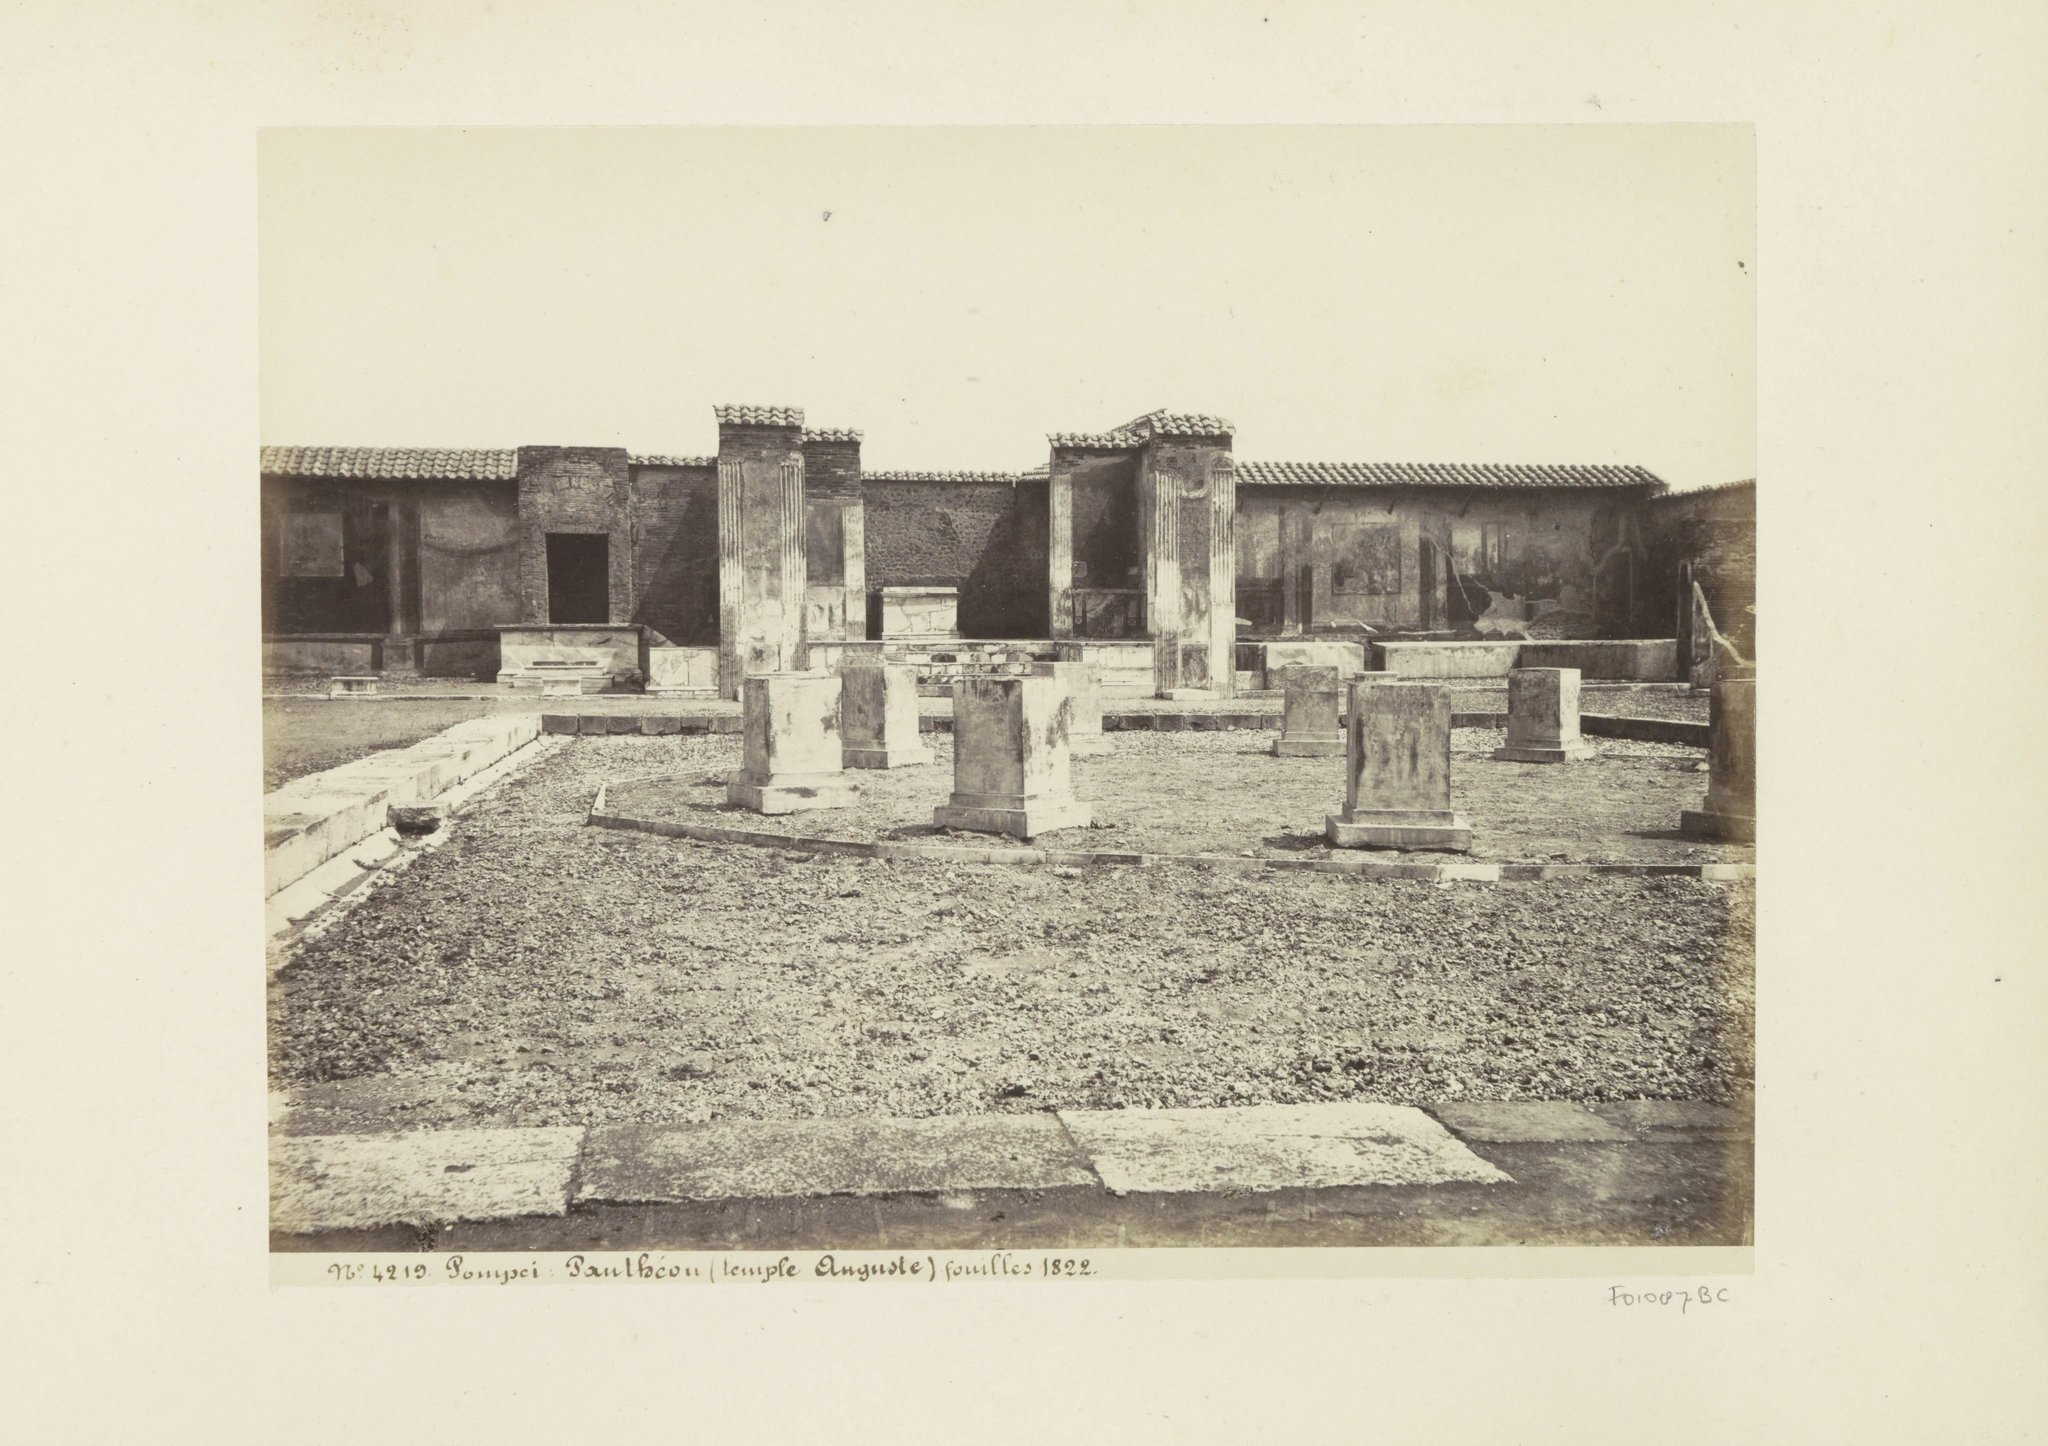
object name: photograph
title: Pompei: Panthéon (temple Auguste) fouilles 1822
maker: Anonymous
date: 1865-1875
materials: paper, photographic support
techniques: albumen print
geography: pompeii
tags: column, pillar ~ architecture, temple, shrine ~ non-christian religions, excavation ~ archaeology, pompeii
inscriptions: negative number: ‘4219’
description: Onderdeel van Reisalbum met foto's van bezienswaardigheden in Napels en omgeving.